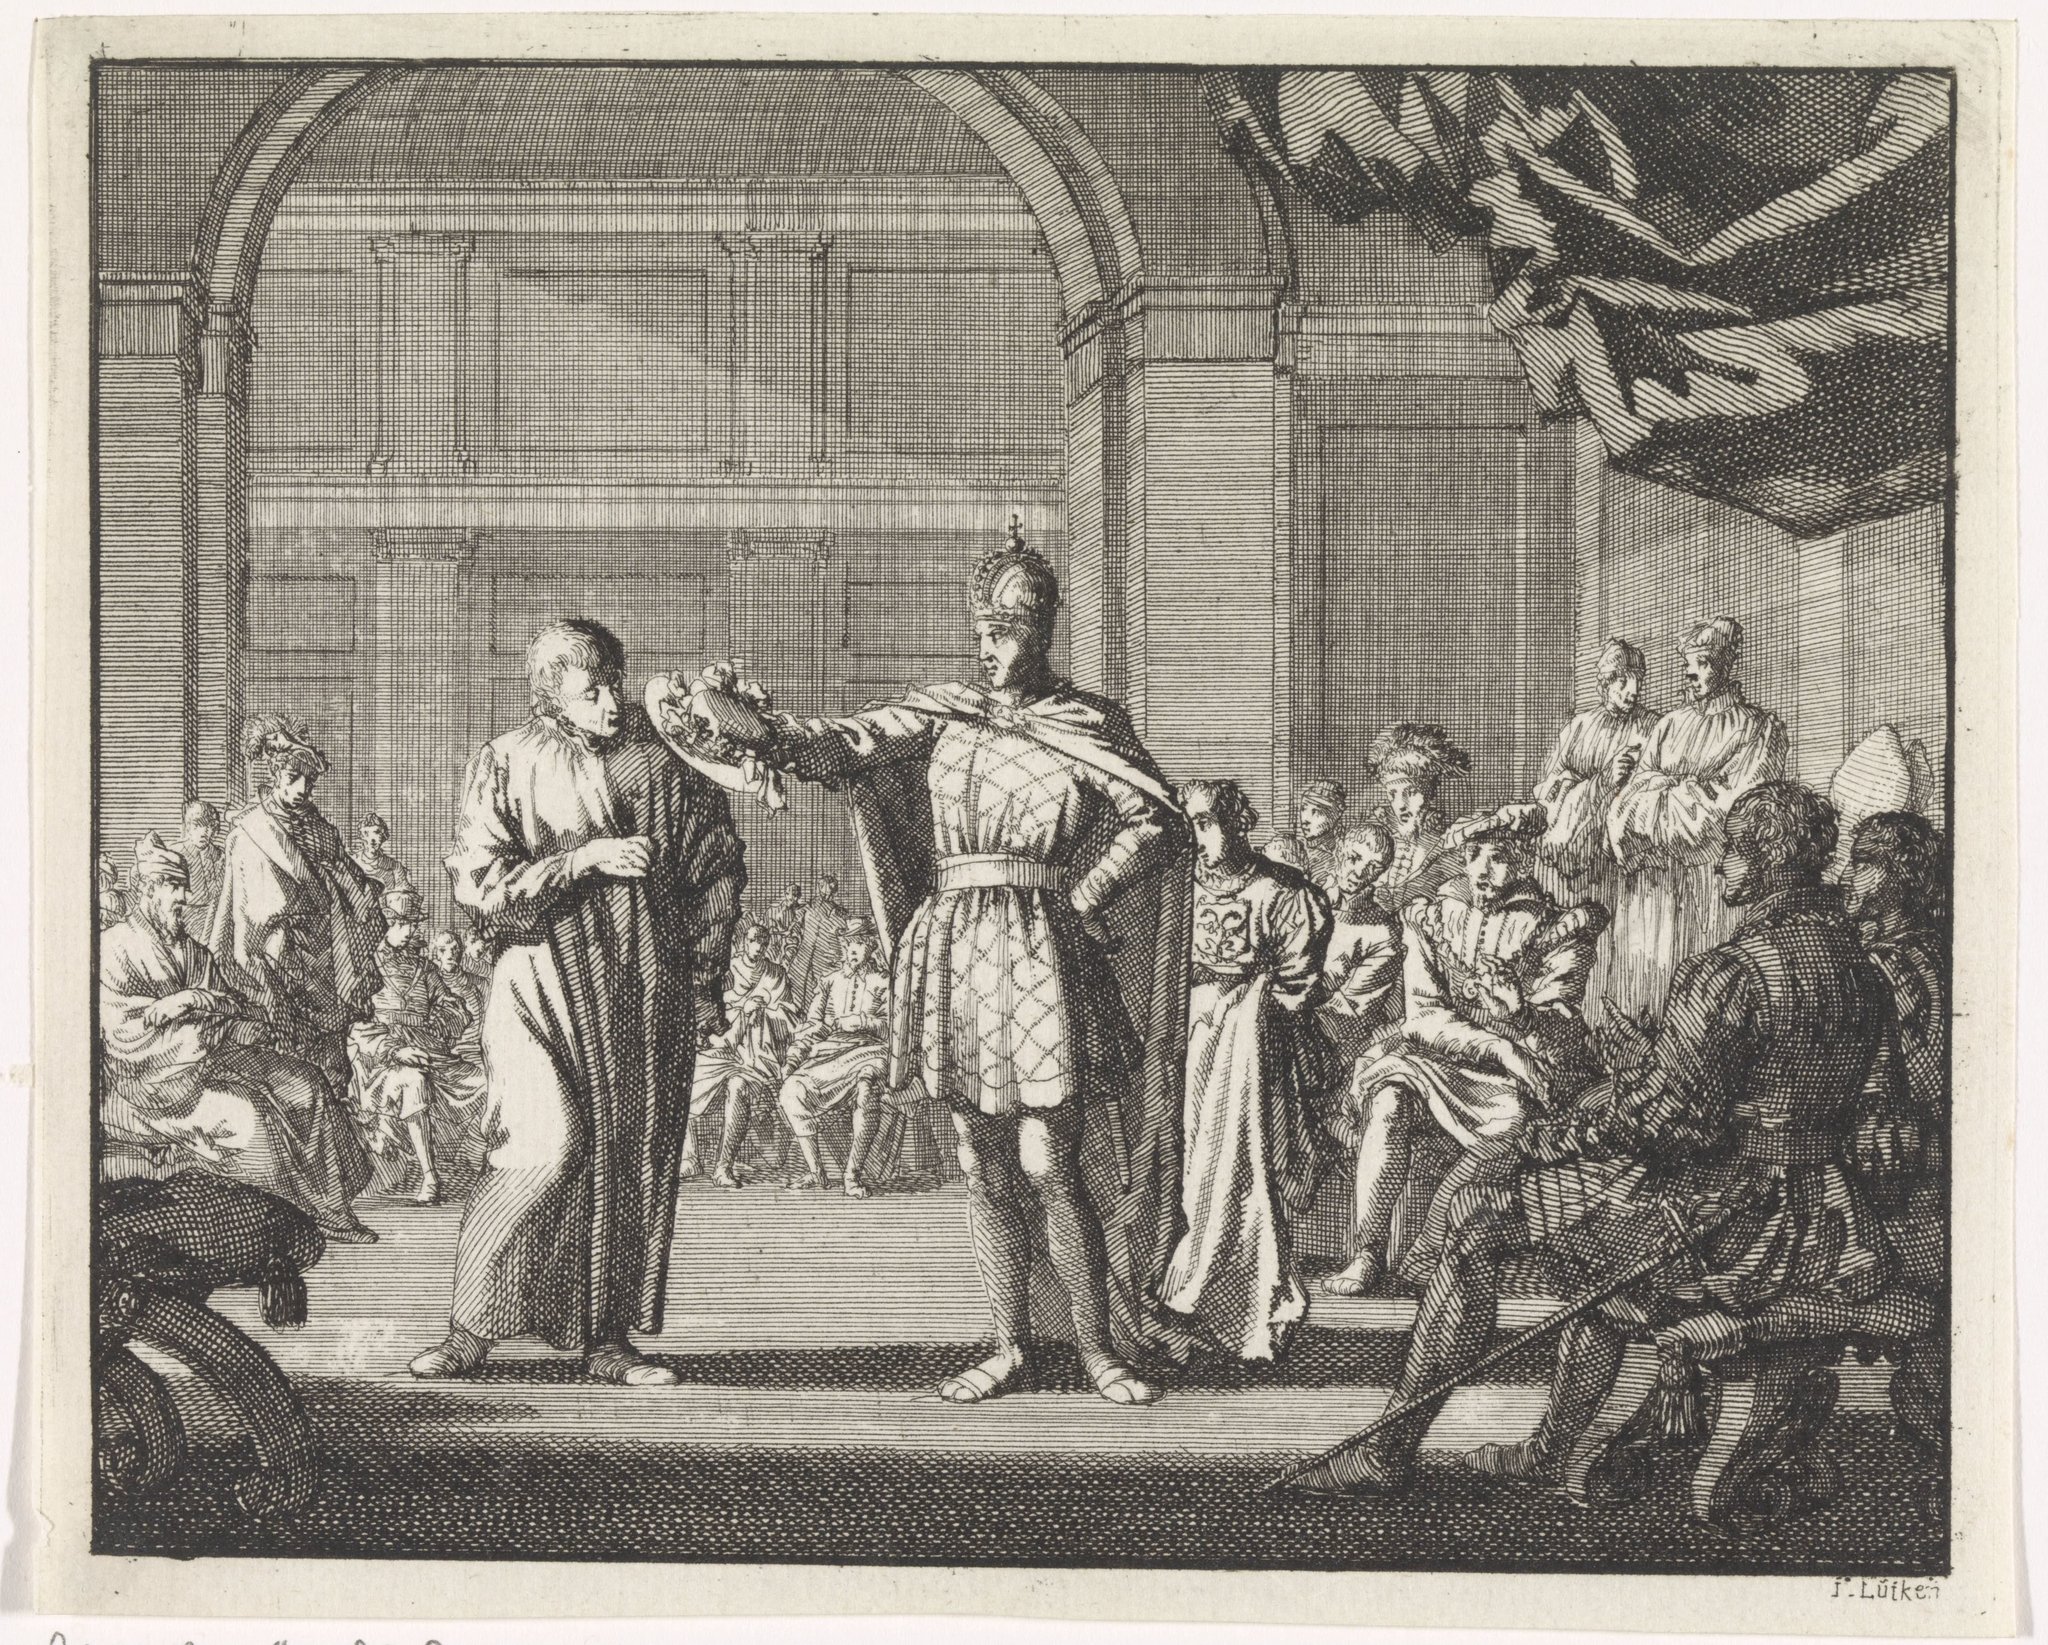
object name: print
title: De keizer neemt een kanunnik zijn rijkelijk versierde hoed af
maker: jan luyken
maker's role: draughtsman, print maker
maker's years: 1649-1712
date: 1701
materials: paper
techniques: etching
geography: amsterdam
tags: the early christian churches, e.g. armenians, copts, syrians, head-gear: hat (+ men's clothes), emperor, regular clerics, e.g. jesuits, redemptorists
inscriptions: collector's mark: Lugt 2228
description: Proefdruk van een boekillustratie Arnold, Godfried. Waare afbeelding der eerste christenen. Amsterdam: Jacobus van Hardenberg, Barent Visscher en Jacobus van Nieuweveen, 1700, dl. 2.